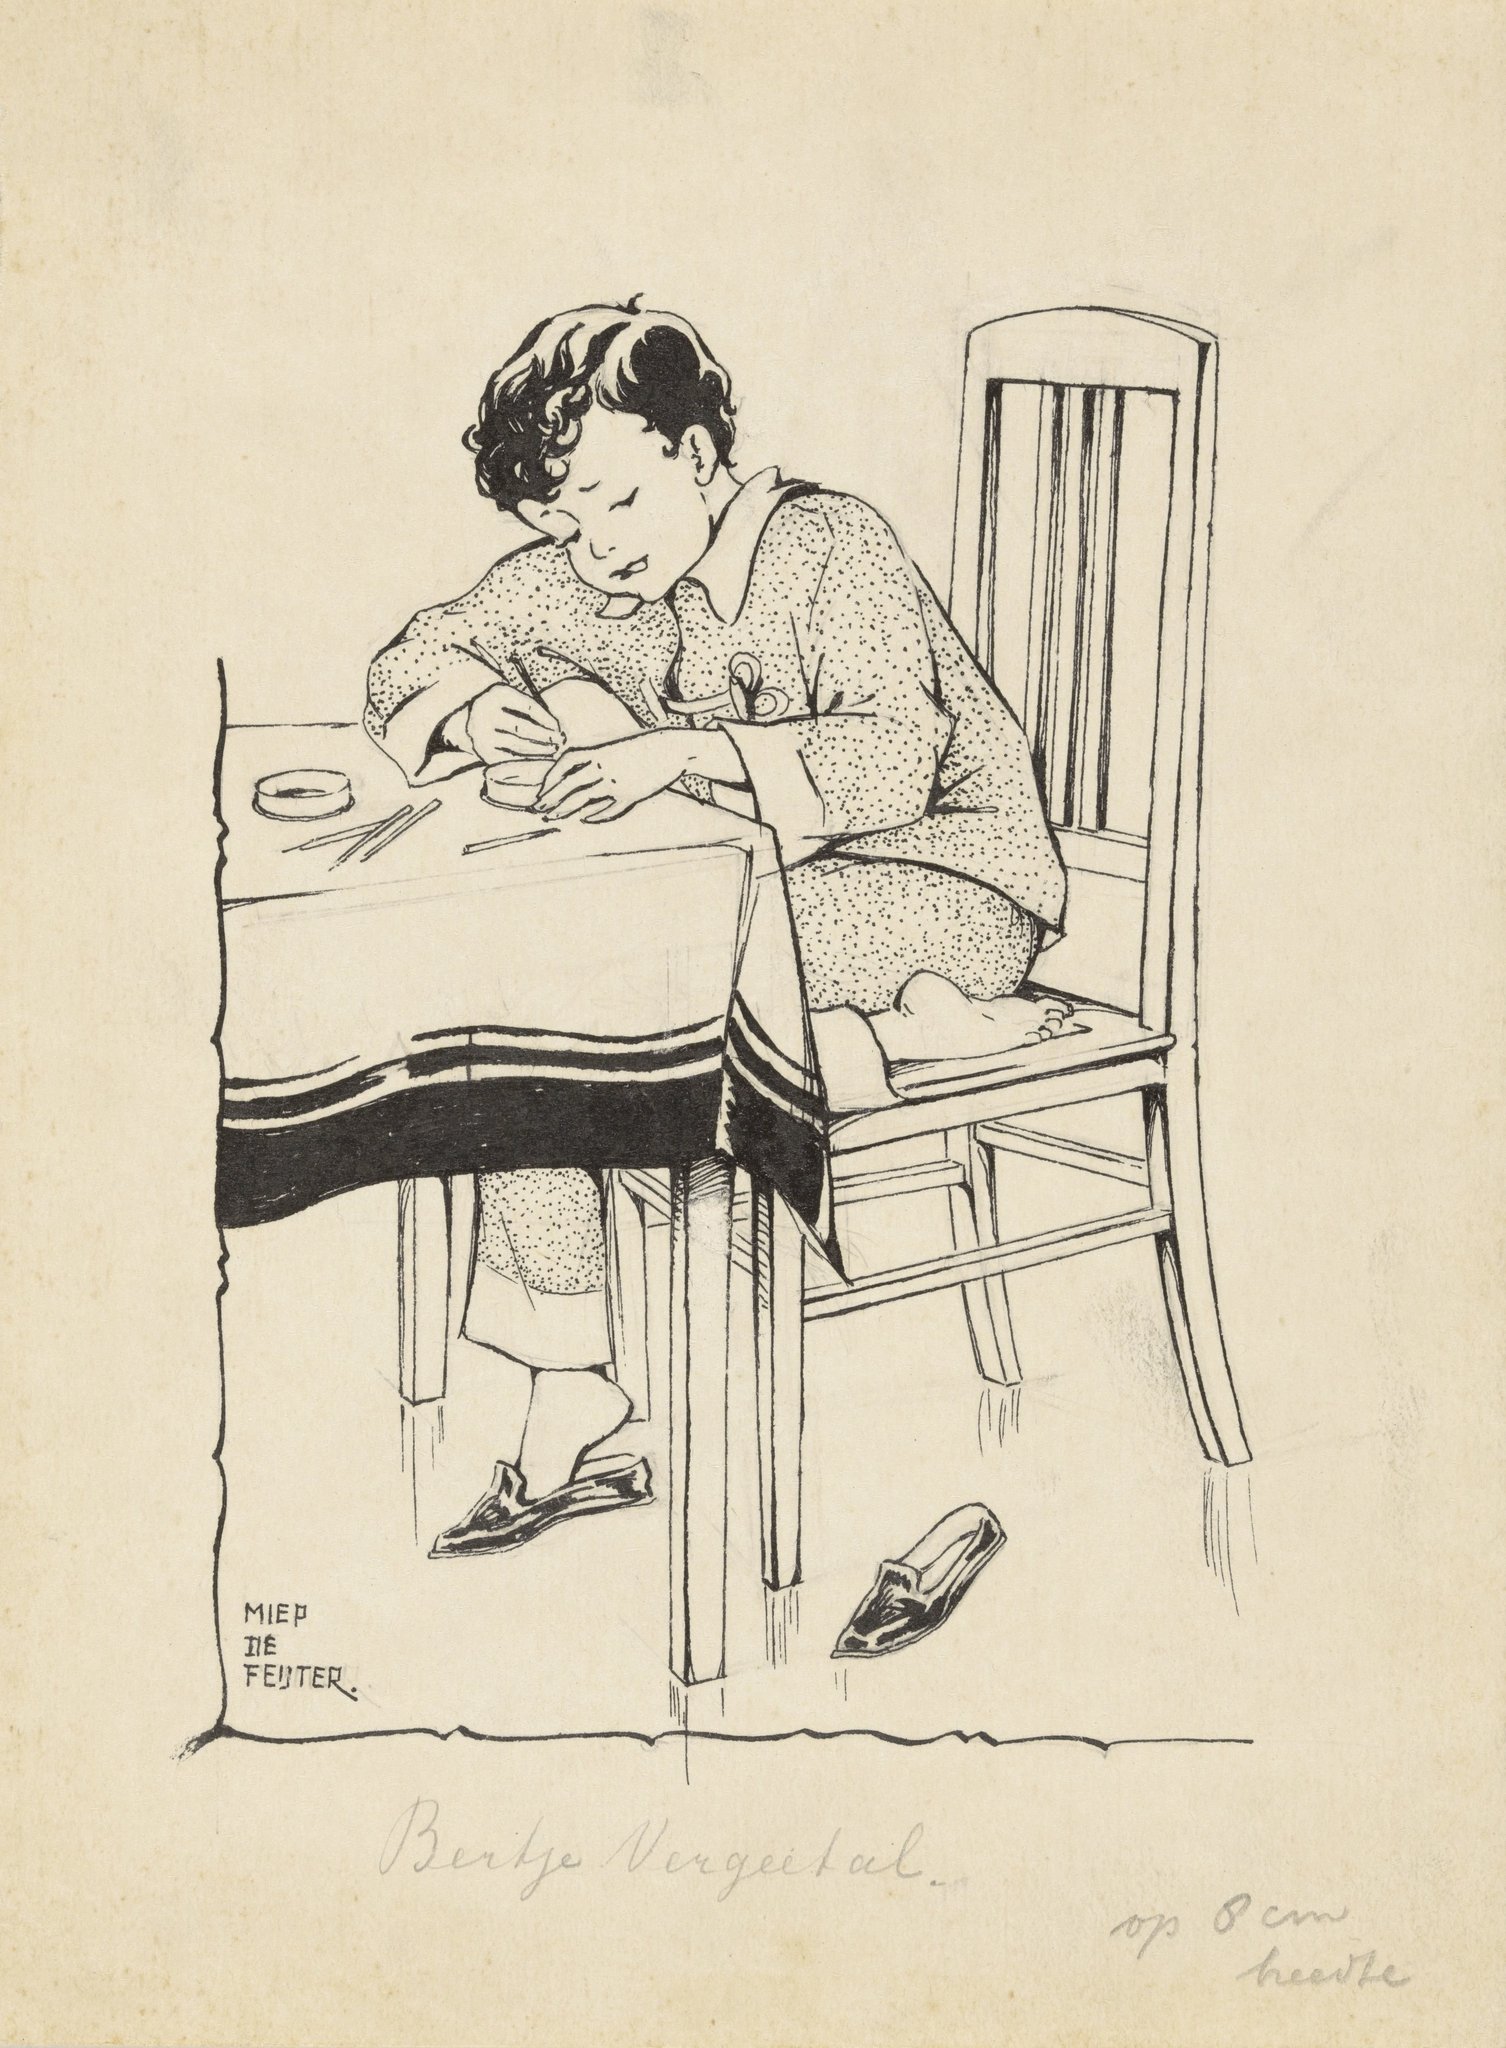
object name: boekillustratie ontwerp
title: Knutselende jongen aan een tafel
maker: miep de feijter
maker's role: draughtsman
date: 1928-1941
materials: ink, paper, pencil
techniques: brush, pen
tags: children's games and plays, boy (child between toddler and youth), table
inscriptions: annotation: ‘Bertje Vergeetal.’, signature: ‘MIEP/ DE/ FEIJTER.’, collector's mark: Lugt 2228a, :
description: Een jongen zit in zijn pyjama aan een met een tafelkleed overdekte tafel te knutselen. Hij heeft een stokje of schrijfgerei in de hand.